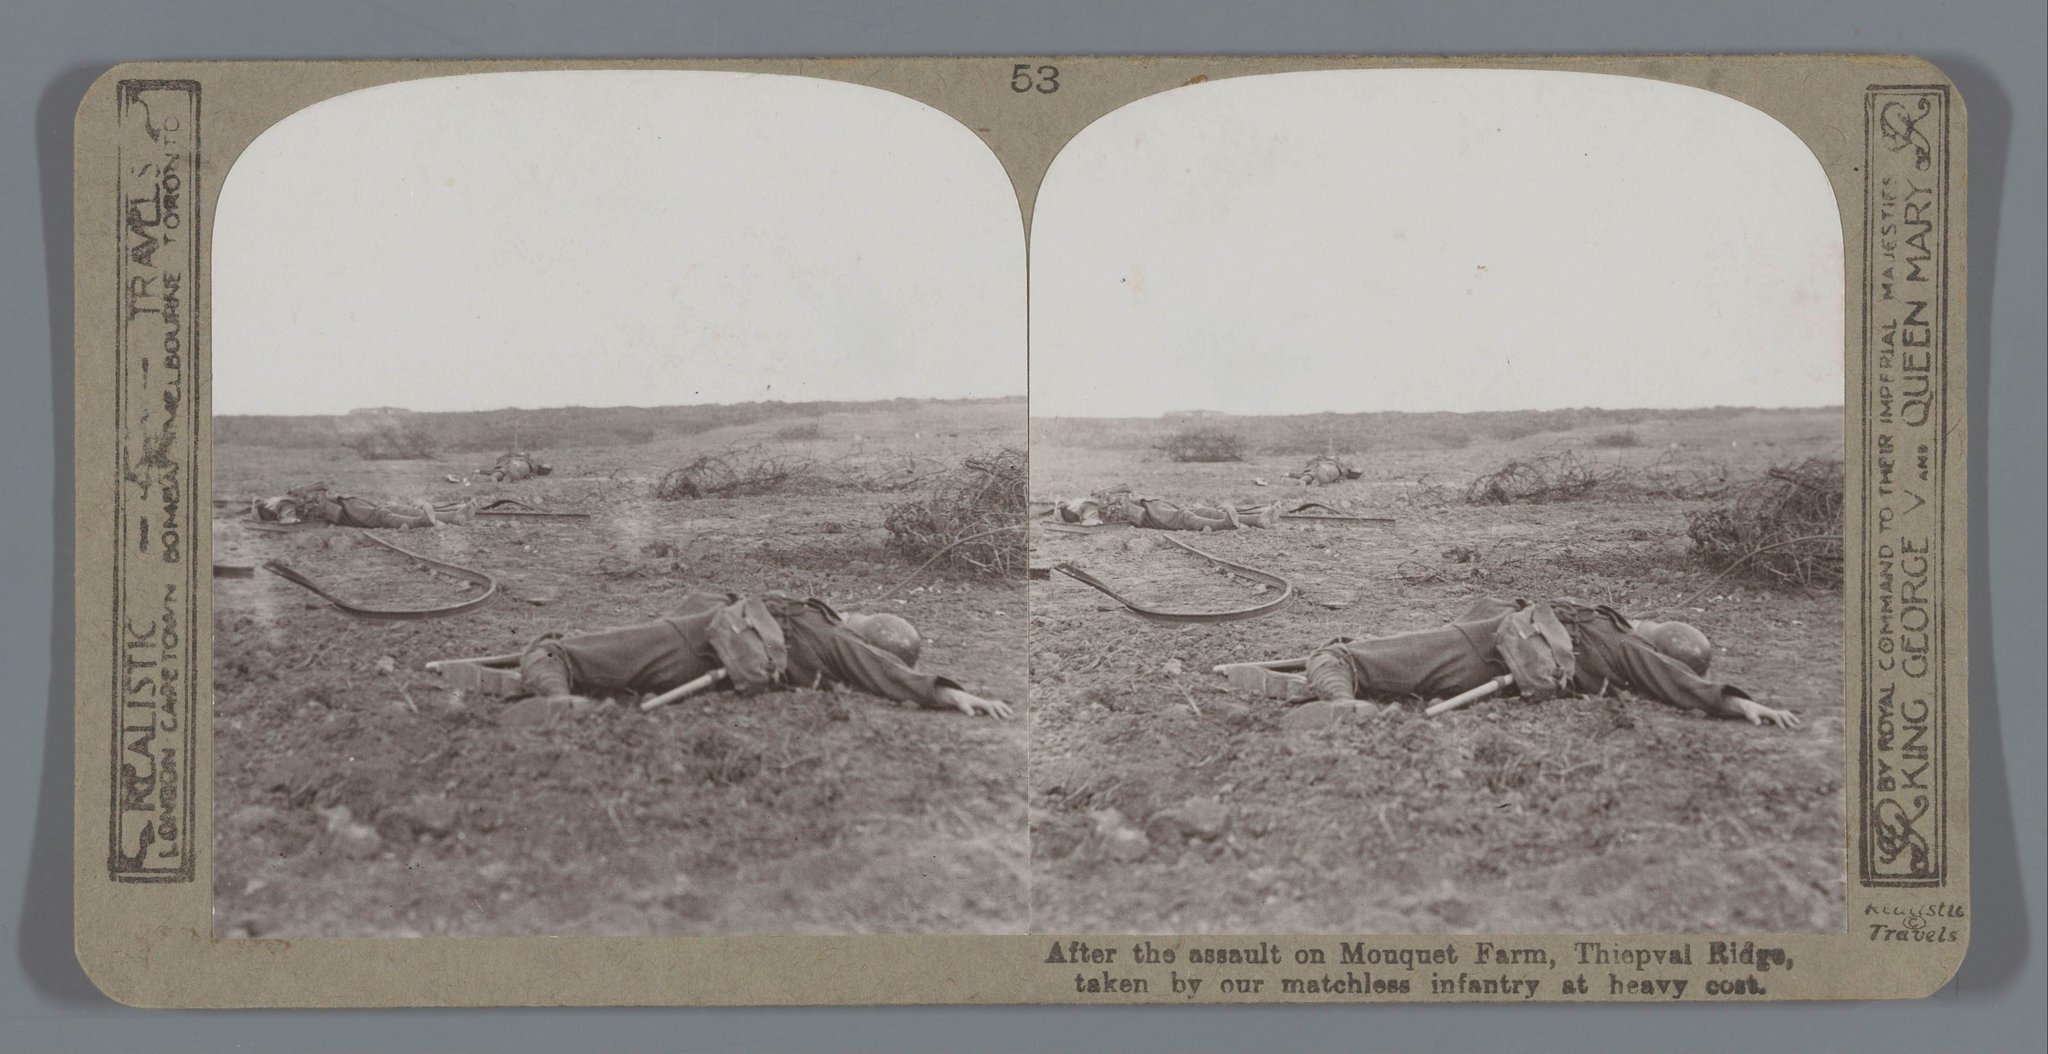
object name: stereograph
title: After the assault on Mouquet Farm, Thiepval Ridge, taken by our matchless infantry at heavy costs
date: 1914-1918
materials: cardboard, photographic support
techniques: gelatin silver print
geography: picardy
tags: private soldier, the corpse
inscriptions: number: ‘53’, inscription: ‘By Royal command to their Imperial majesties King George V and Queen Mary’